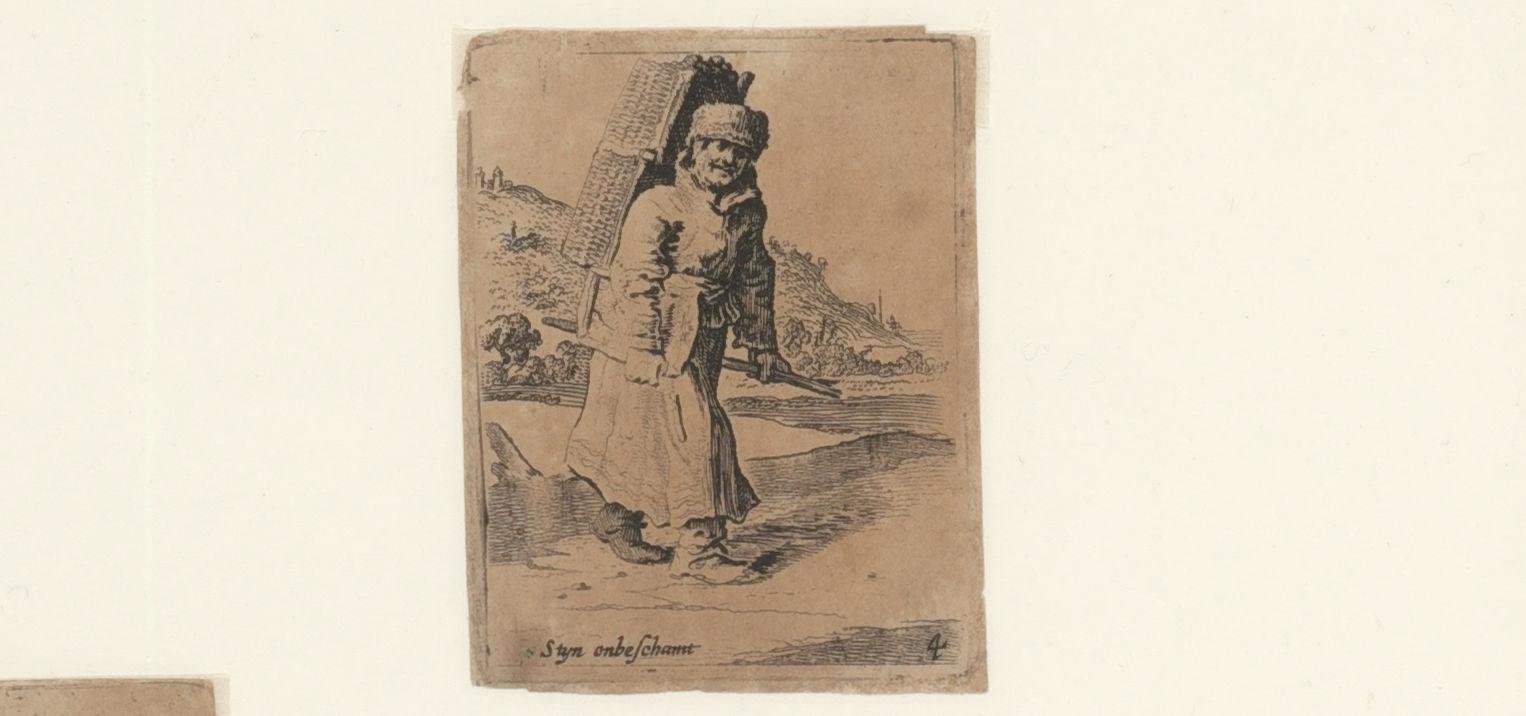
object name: print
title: Genretaferelen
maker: gillis van scheyndel (i)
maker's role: draughtsman, print maker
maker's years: 1595-1660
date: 1638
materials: paper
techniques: etching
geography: netherlands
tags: pedlar, carrying something in basket, bag, rucksack, etc.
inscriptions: collector's mark: Lugt 1641, collector's mark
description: Een man met een muts en op de rug een grote mand loopt naar rechts. Op de achtergrond een heuvel. De prent maakt deel uit van een serie van 32 prenten met genretaferelen. Rechtsonder genummerd: 4. Onderwerpsrubrieken binnen de Atlas Zeden en Gewoonten: Mannelijk beroep en bedrijf: Marskramers, straatventers, straatslijpers, bedelaars, straatvertooningen enz.